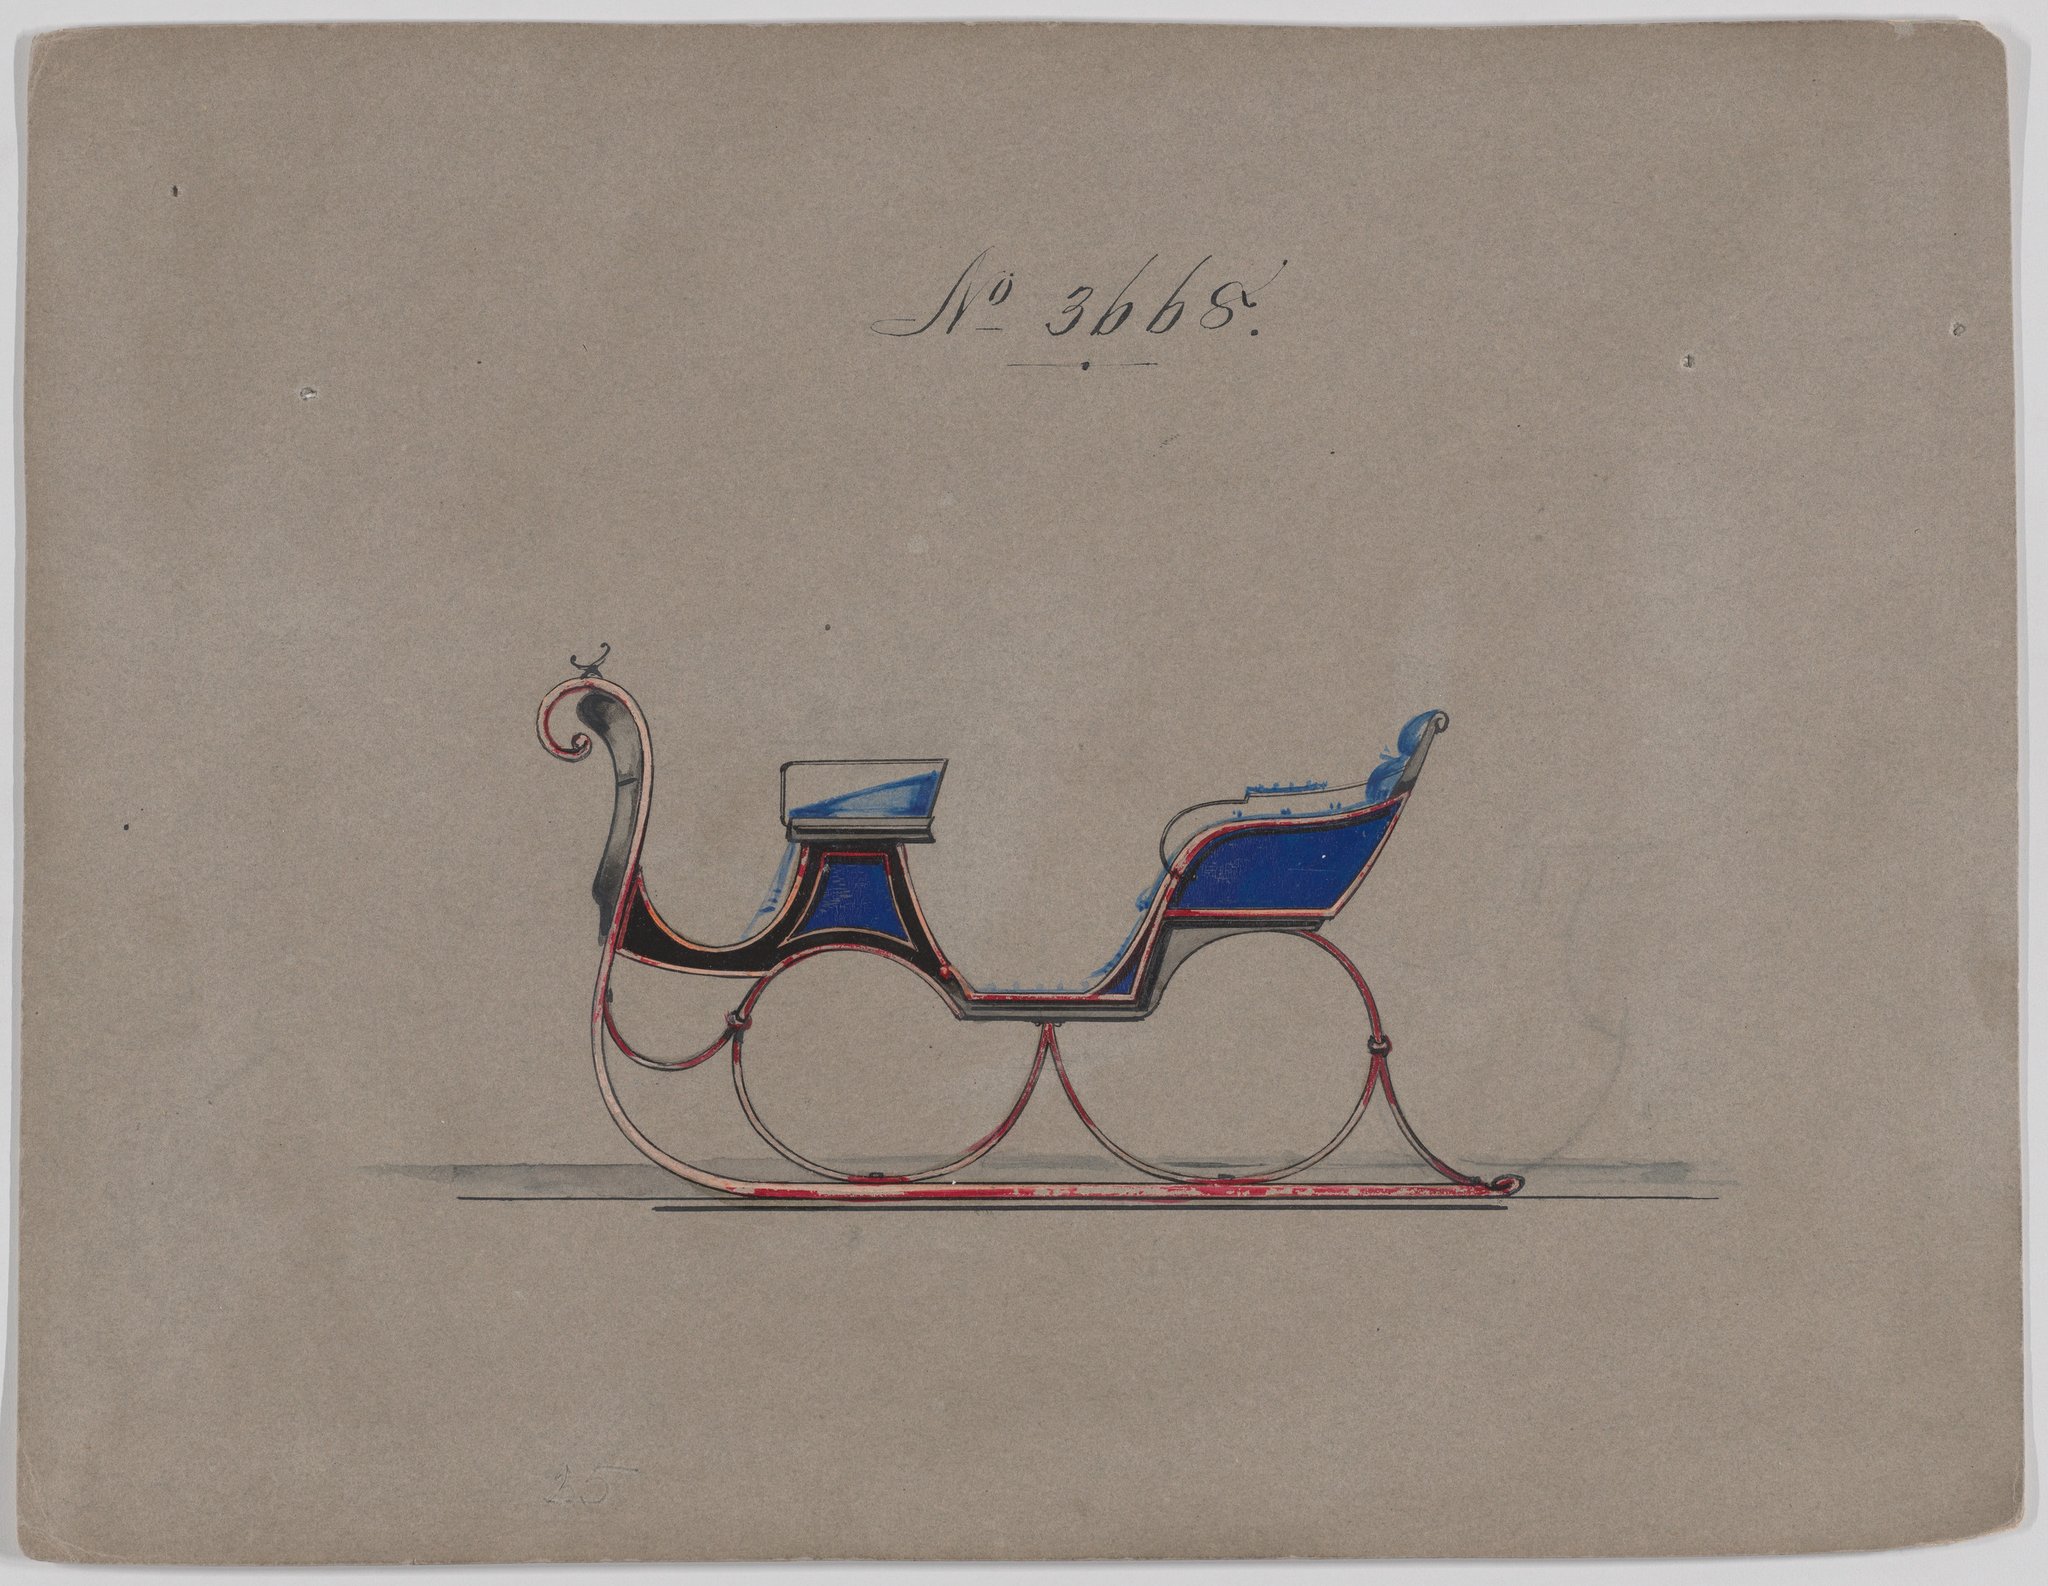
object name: drawing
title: Design for 4 Seat Sleigh, no. 3668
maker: brewster & co.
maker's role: manufacturer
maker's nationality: american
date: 1881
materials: gouache, graphite, ink, watercolor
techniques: pen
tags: sleighs